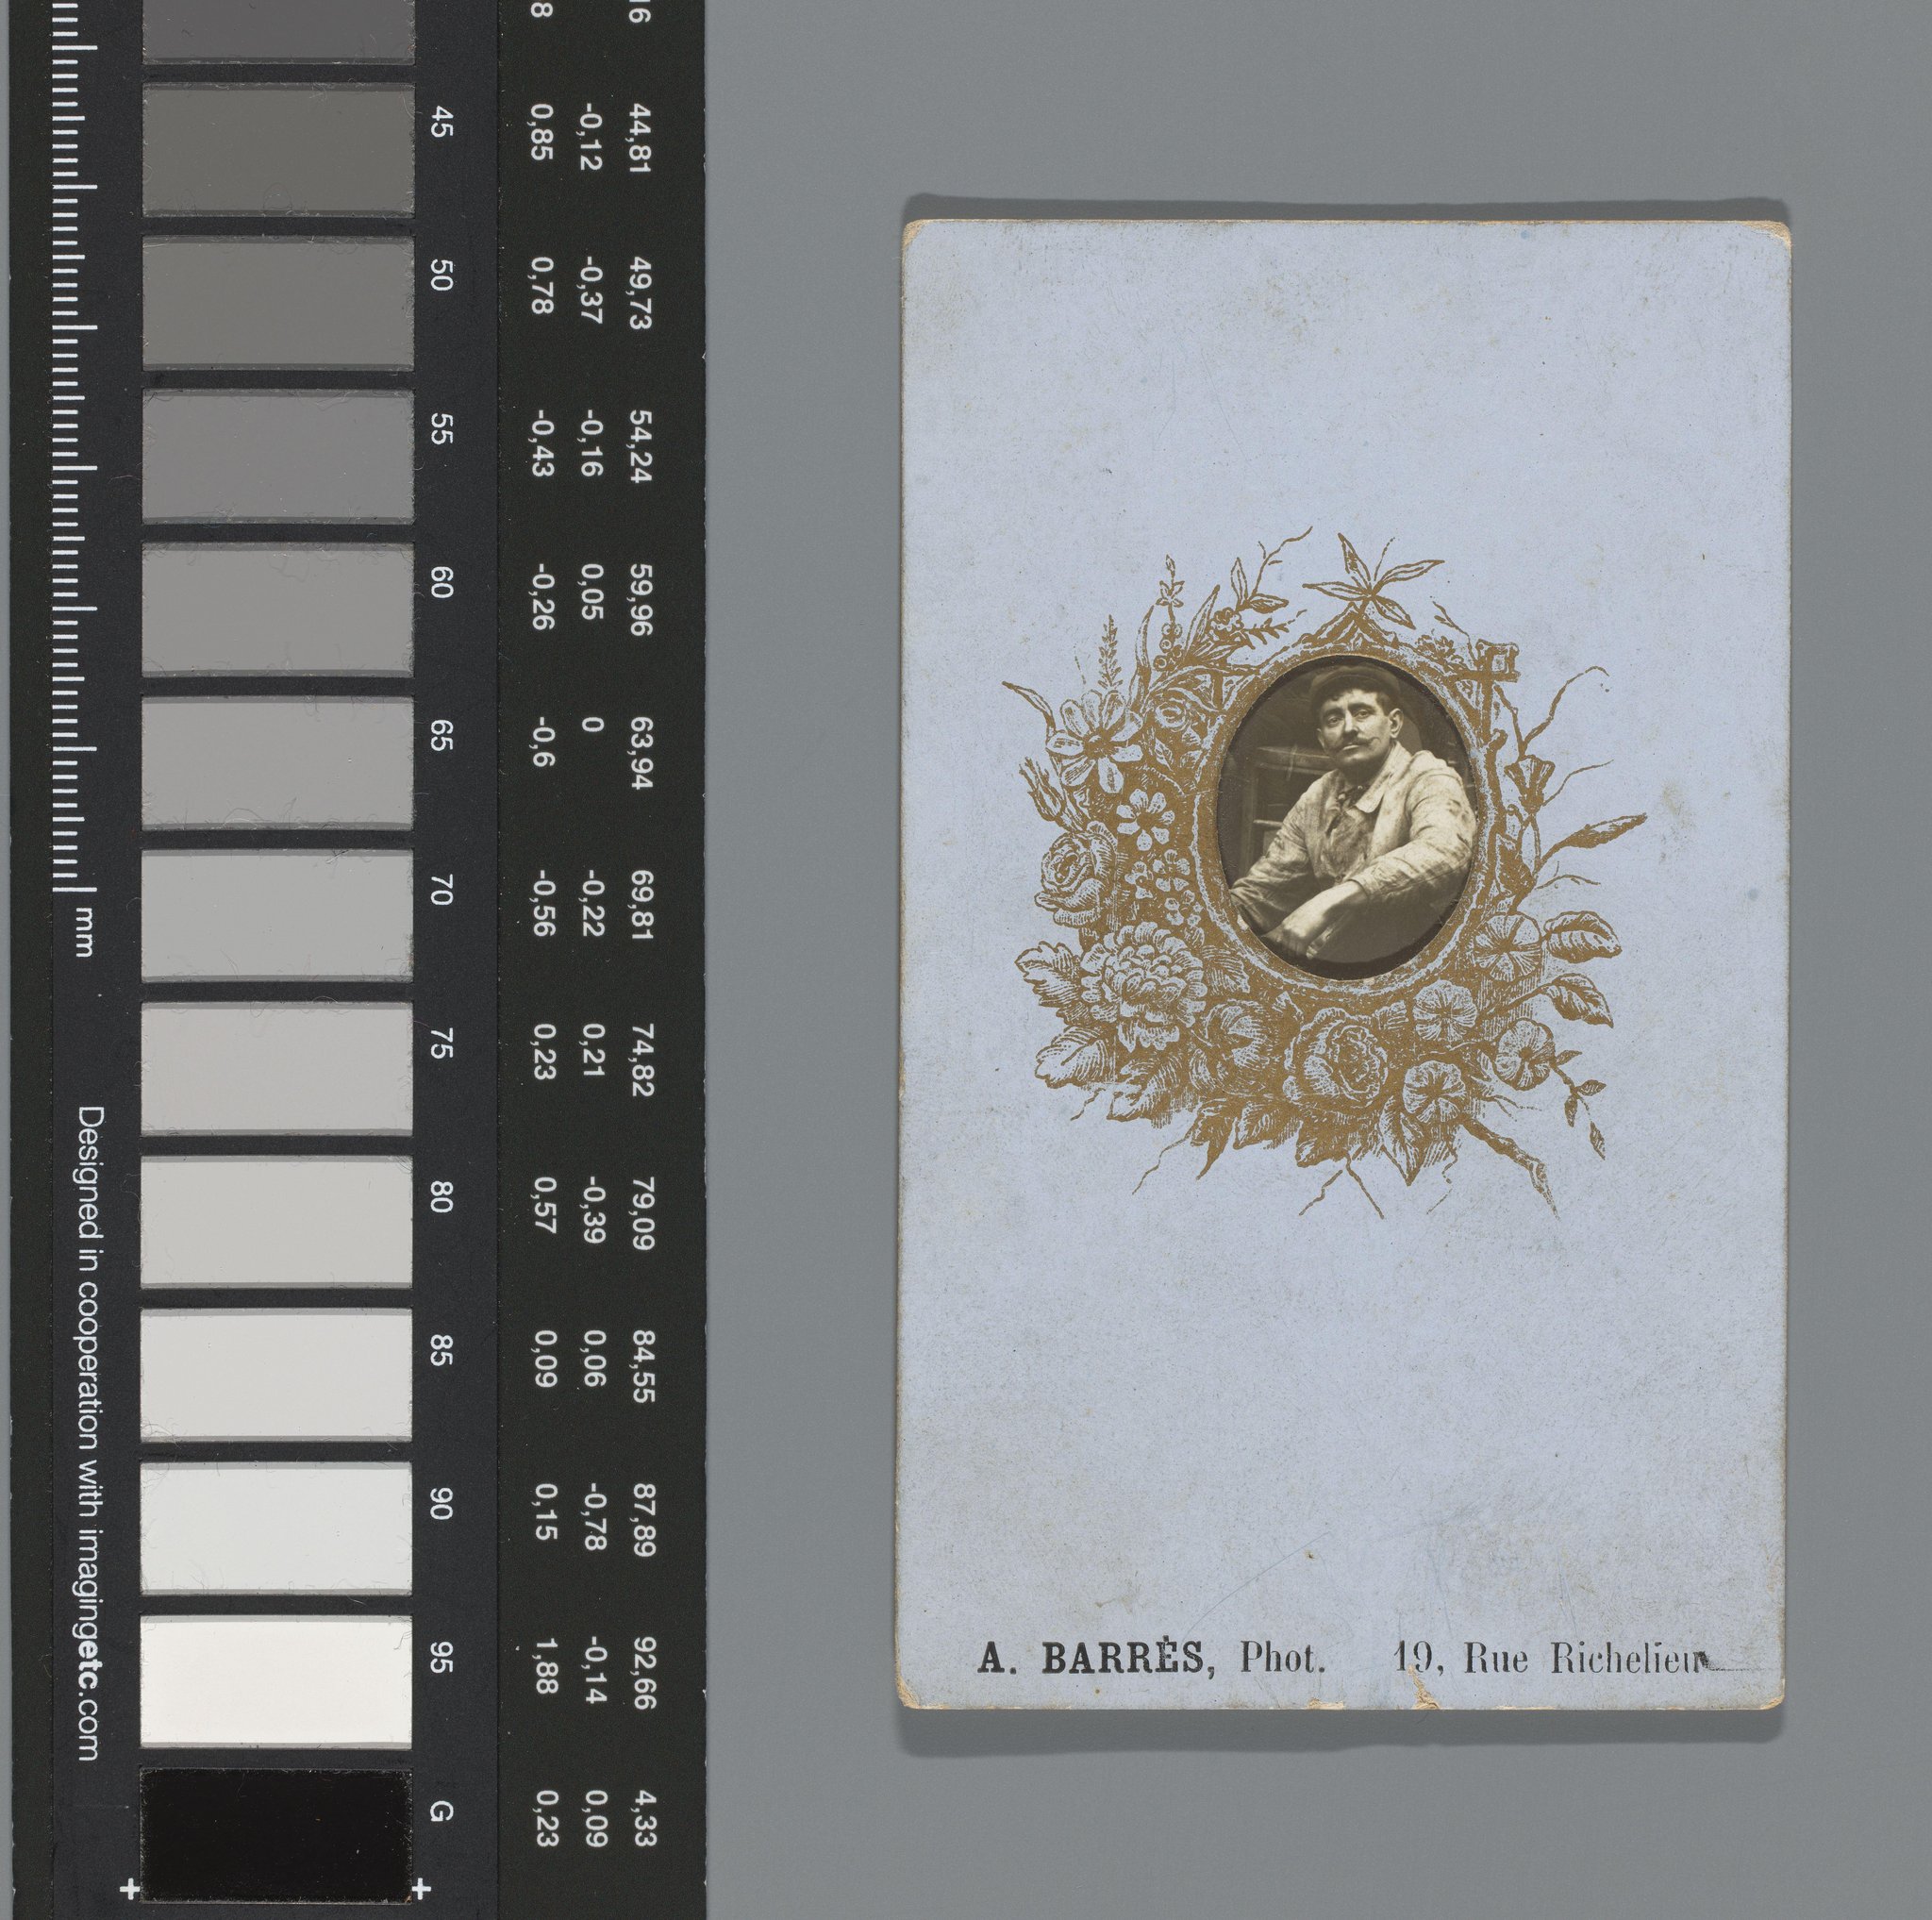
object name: carte de visite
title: Portret van een man omgeven door een gedrukte voorstelling met bloemen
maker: alphonse barrès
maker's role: fotograaf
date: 1860-1890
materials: paper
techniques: ferrotyping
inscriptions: number: ‘54’, name: ‘A. Barrès, Phot. / 19, Rue Richelieu’